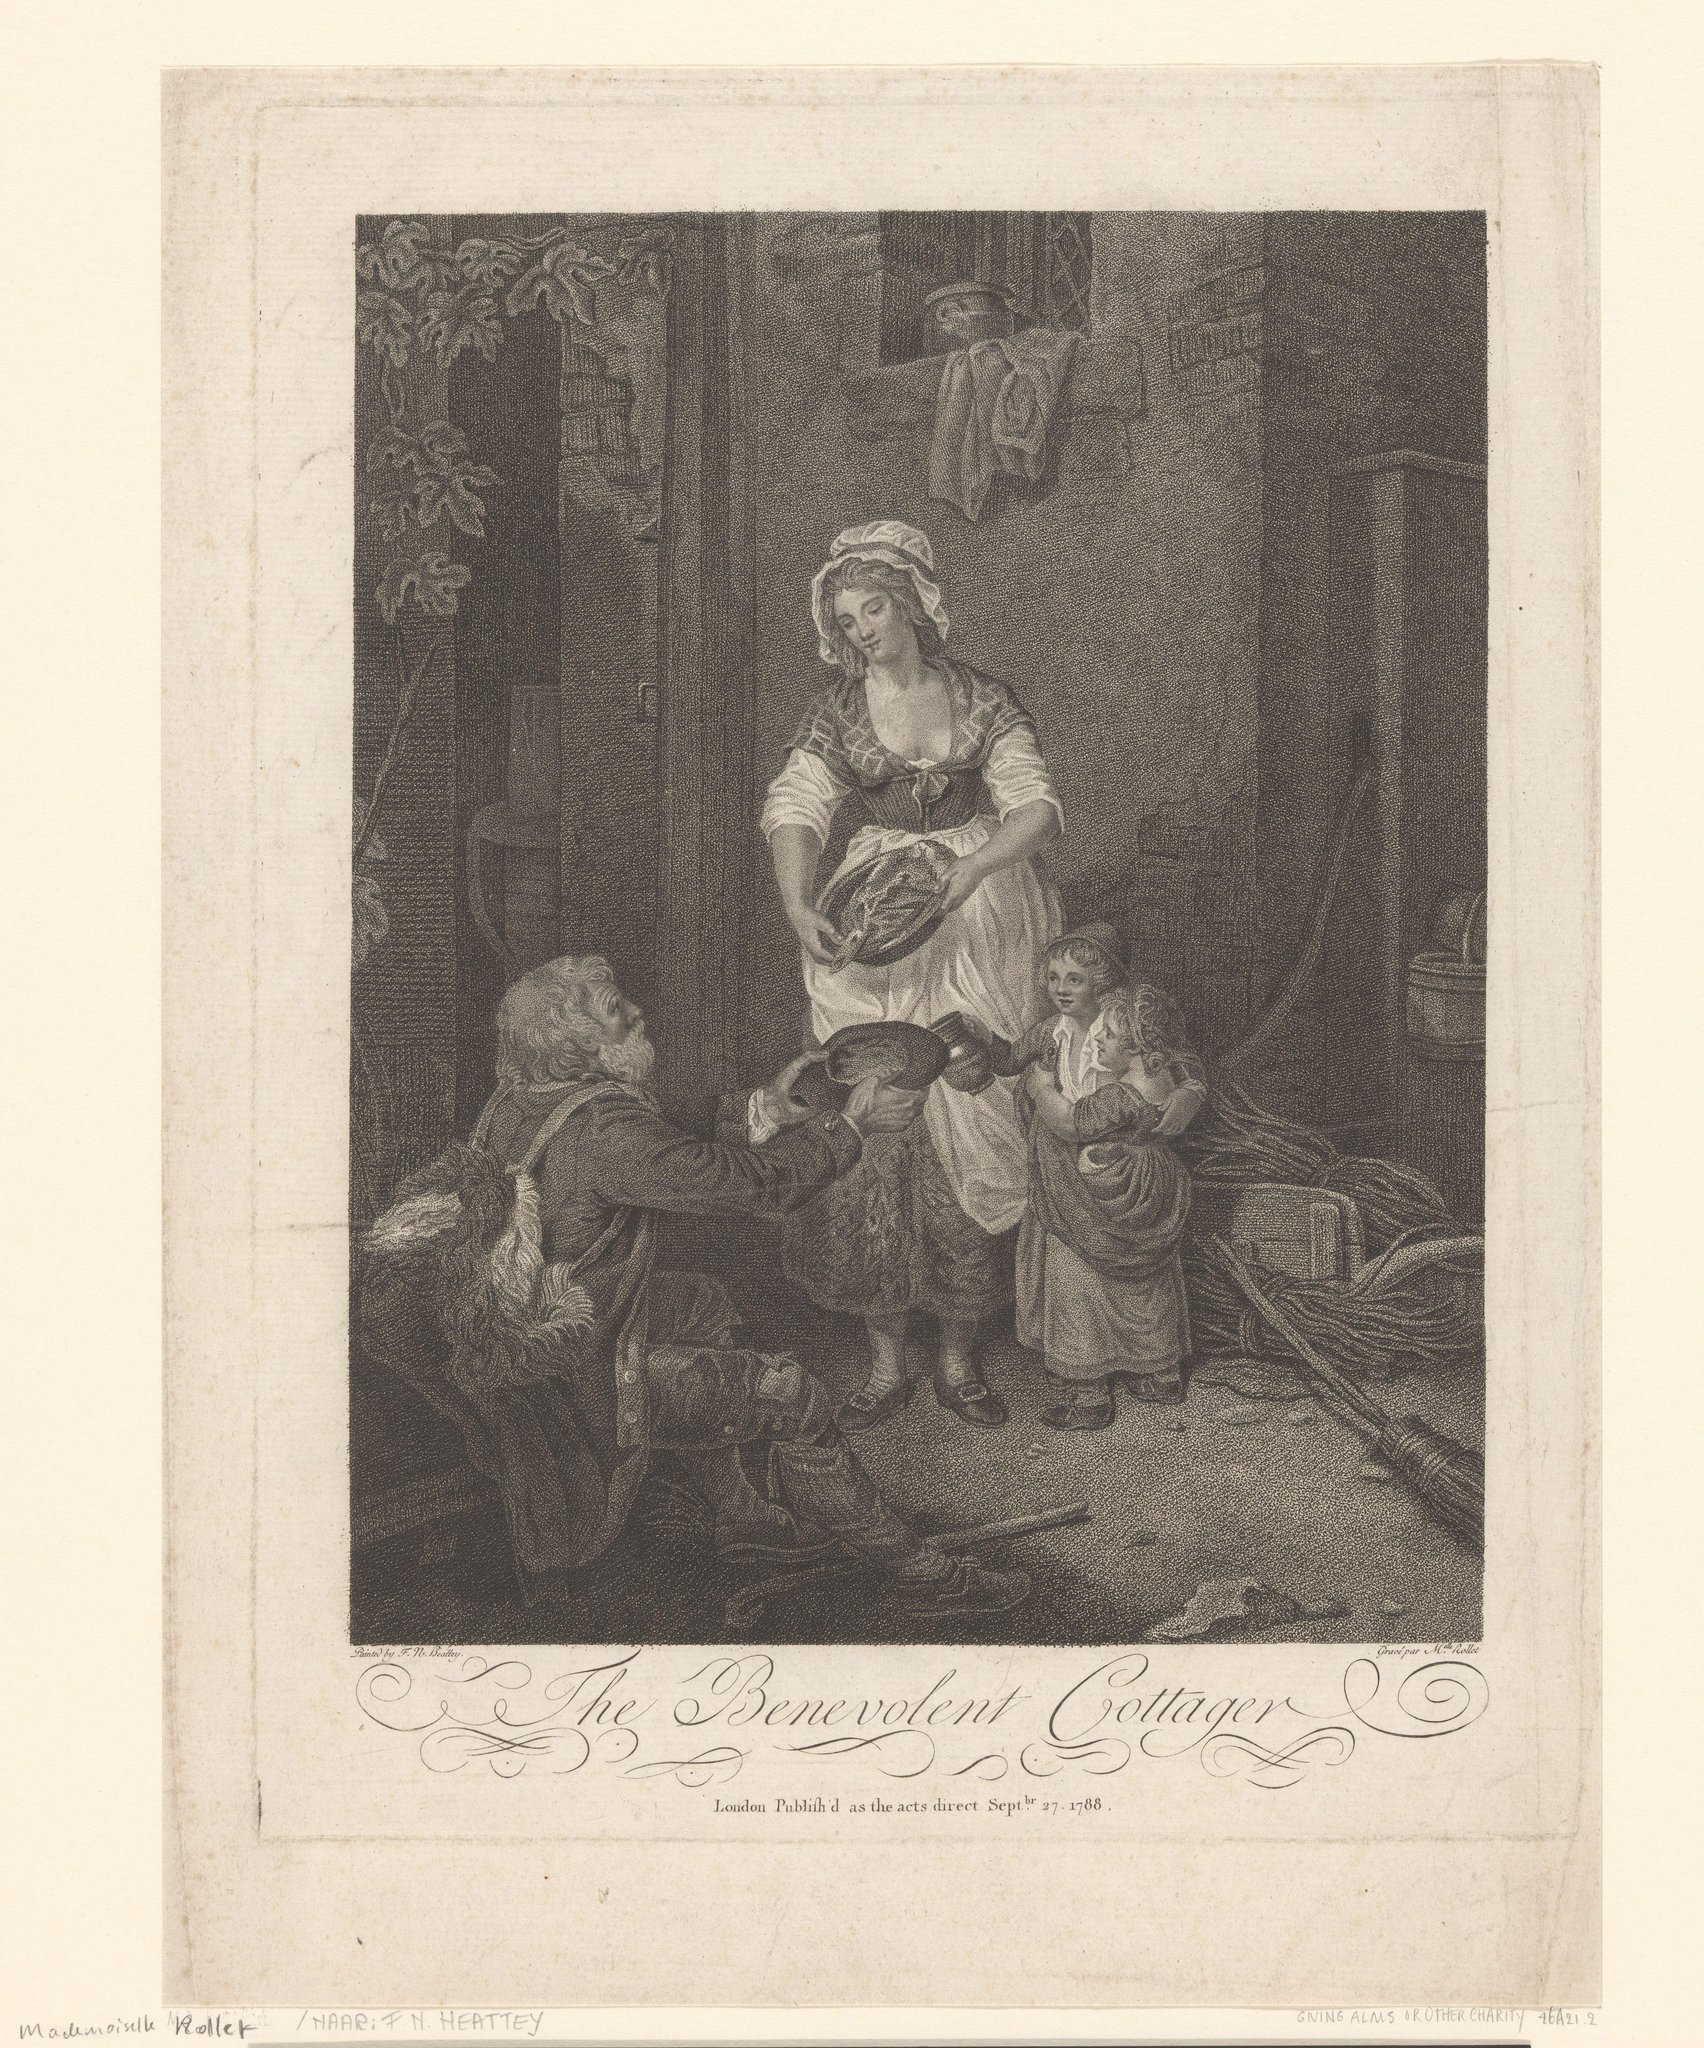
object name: print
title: The Benevolent Cottage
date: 1788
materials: paper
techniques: engraving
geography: london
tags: giving alms or other charity, e.g.: handing out food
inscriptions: collector's mark: Lugt 2228